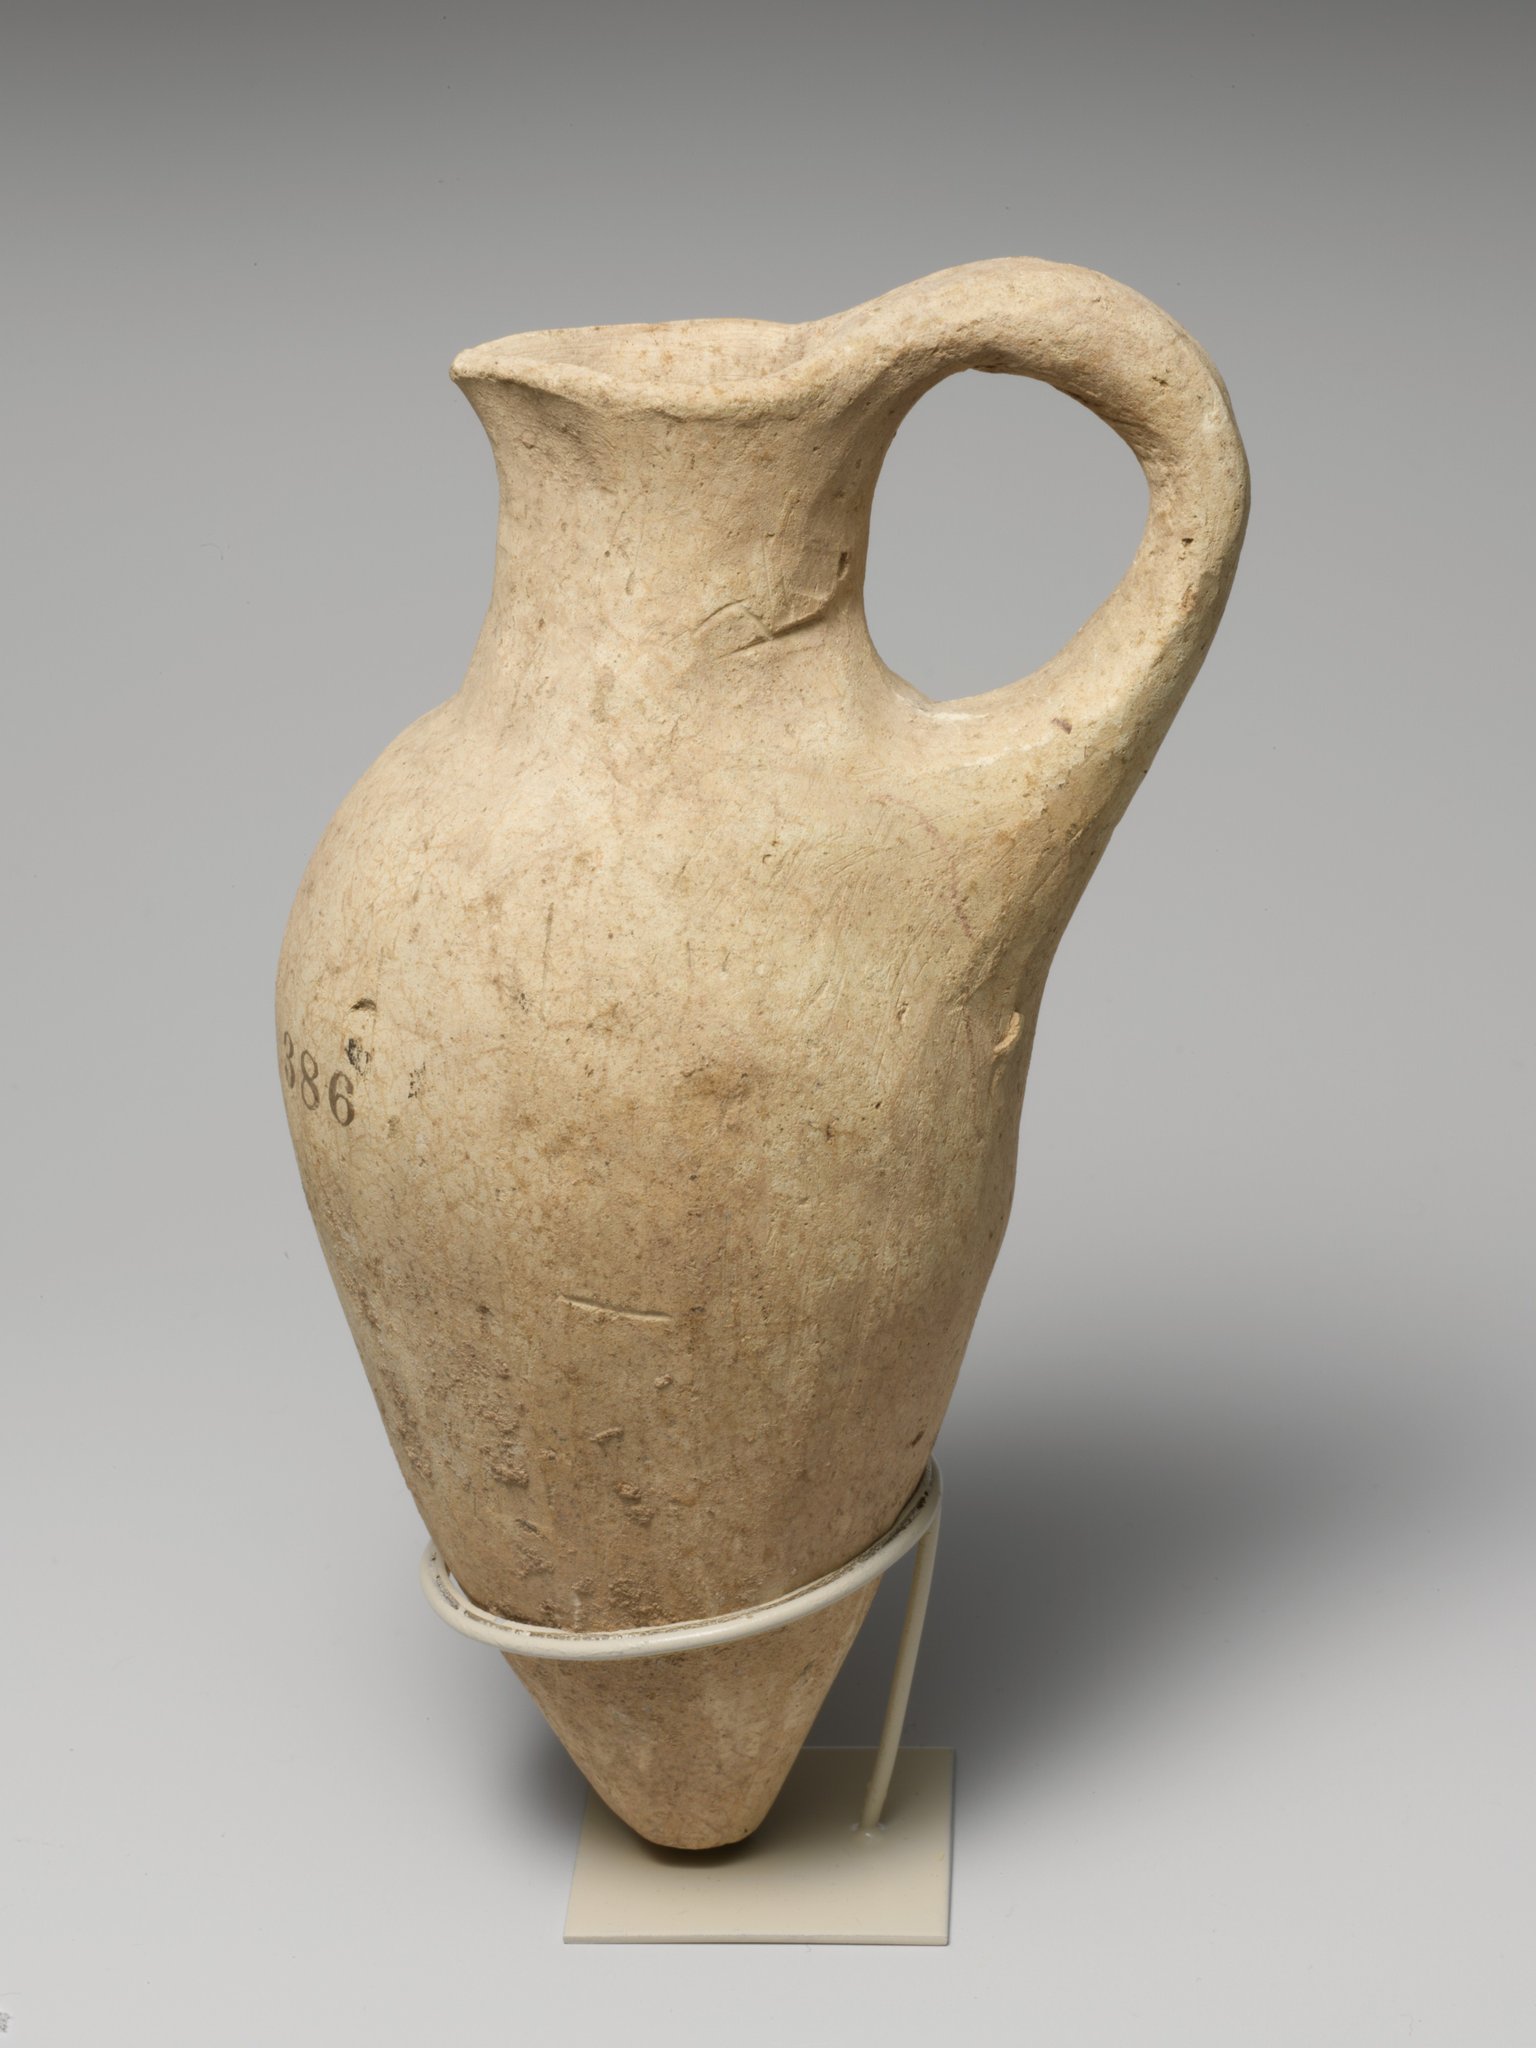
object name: juglet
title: Terracotta white-shaved juglet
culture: cypriot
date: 1600-1050 BCE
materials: terracotta